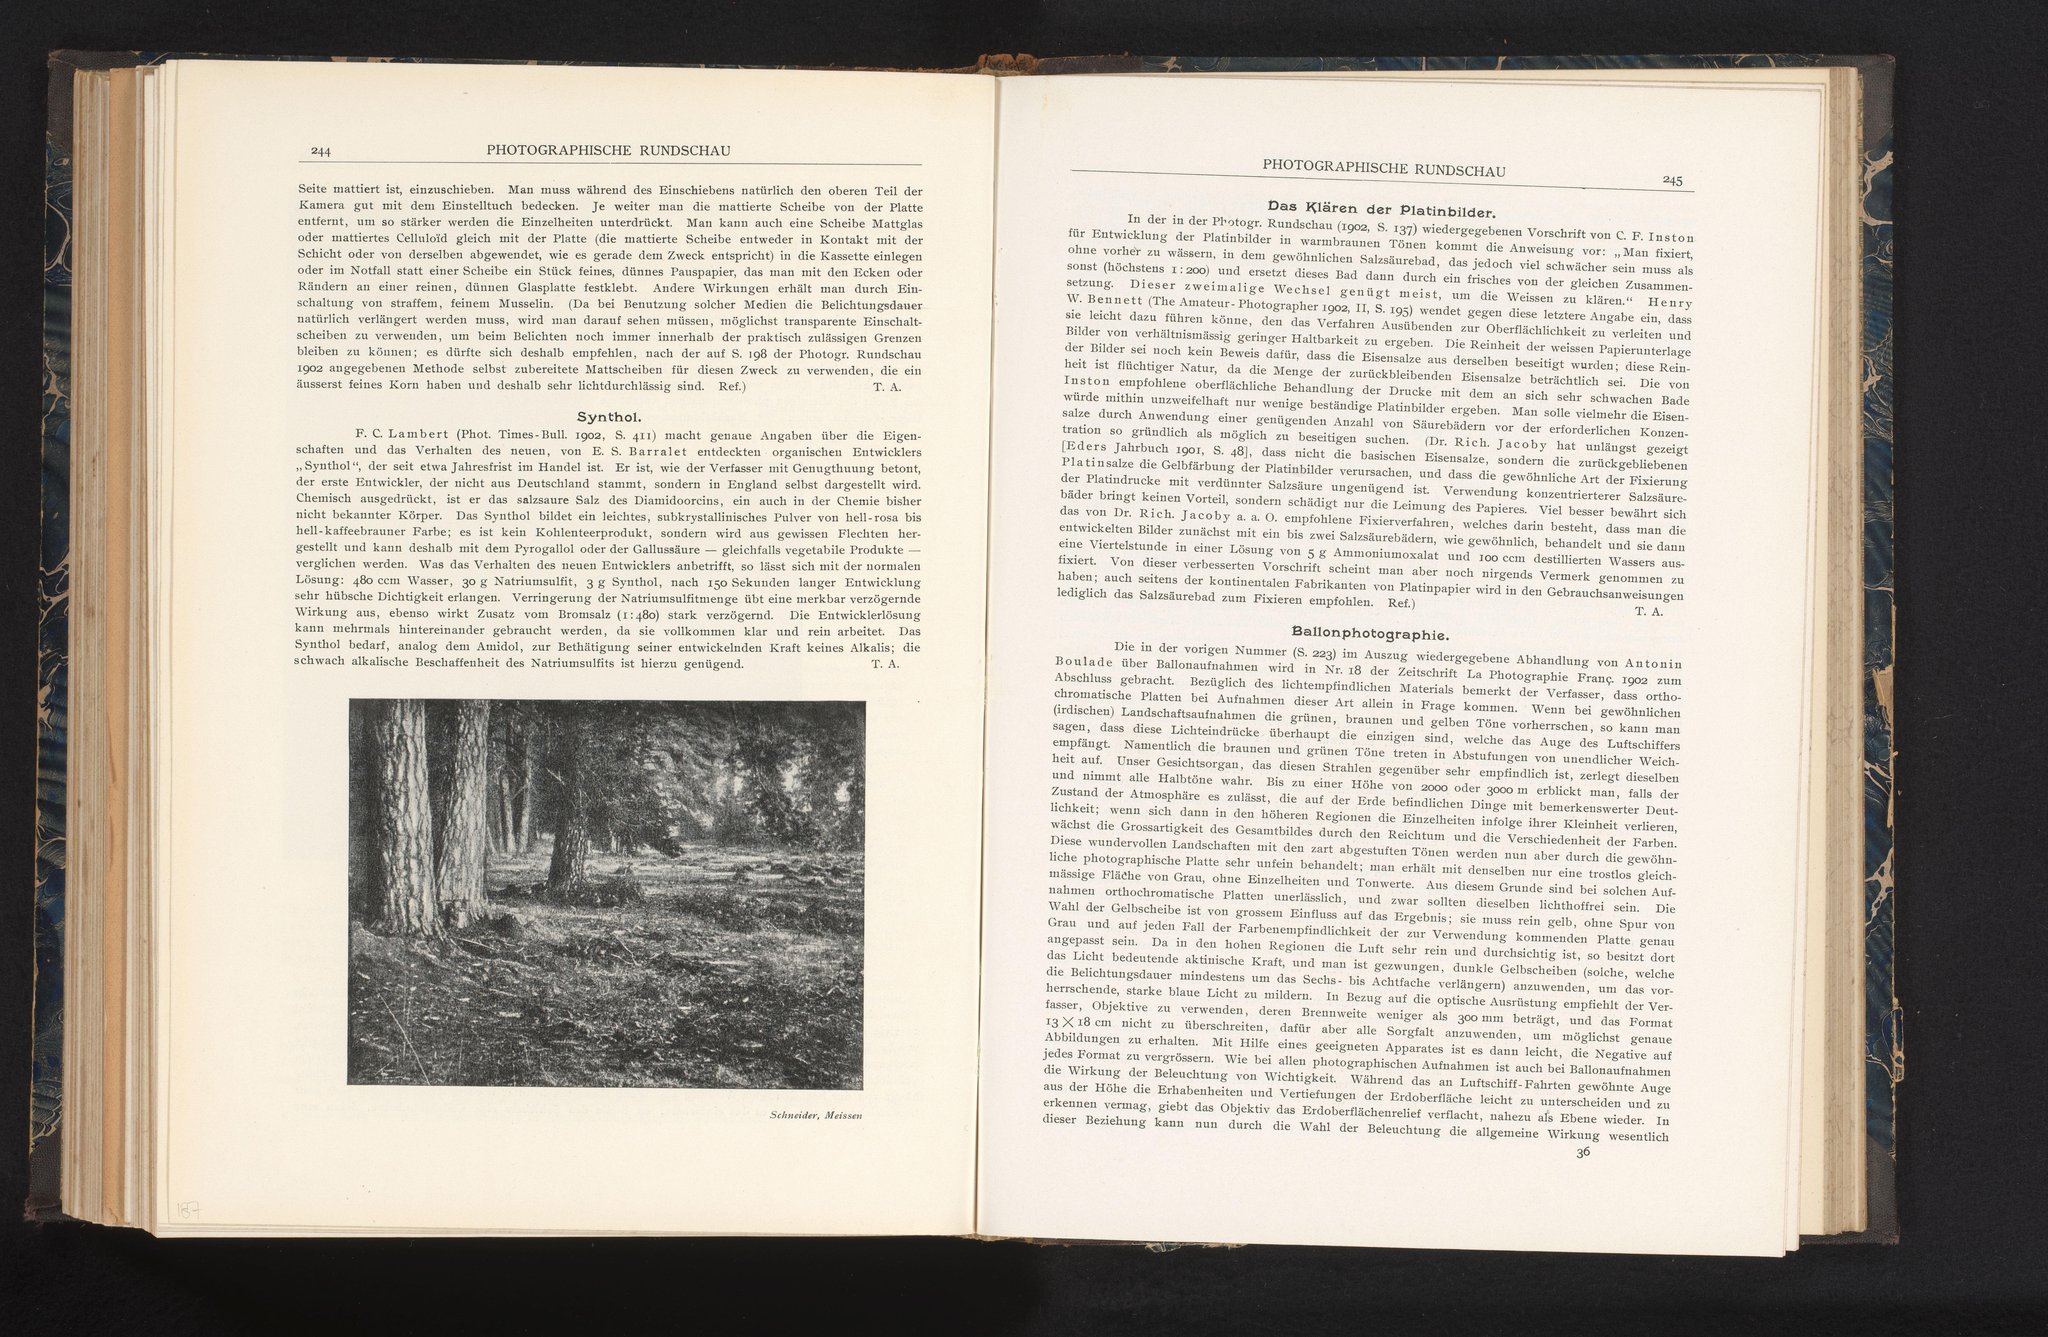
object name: photomechanical print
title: Gezicht op bomen in een bos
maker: alfred schneider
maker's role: fotograaf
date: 1897-1902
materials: paper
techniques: autotype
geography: berlin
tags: trees, forest, wood